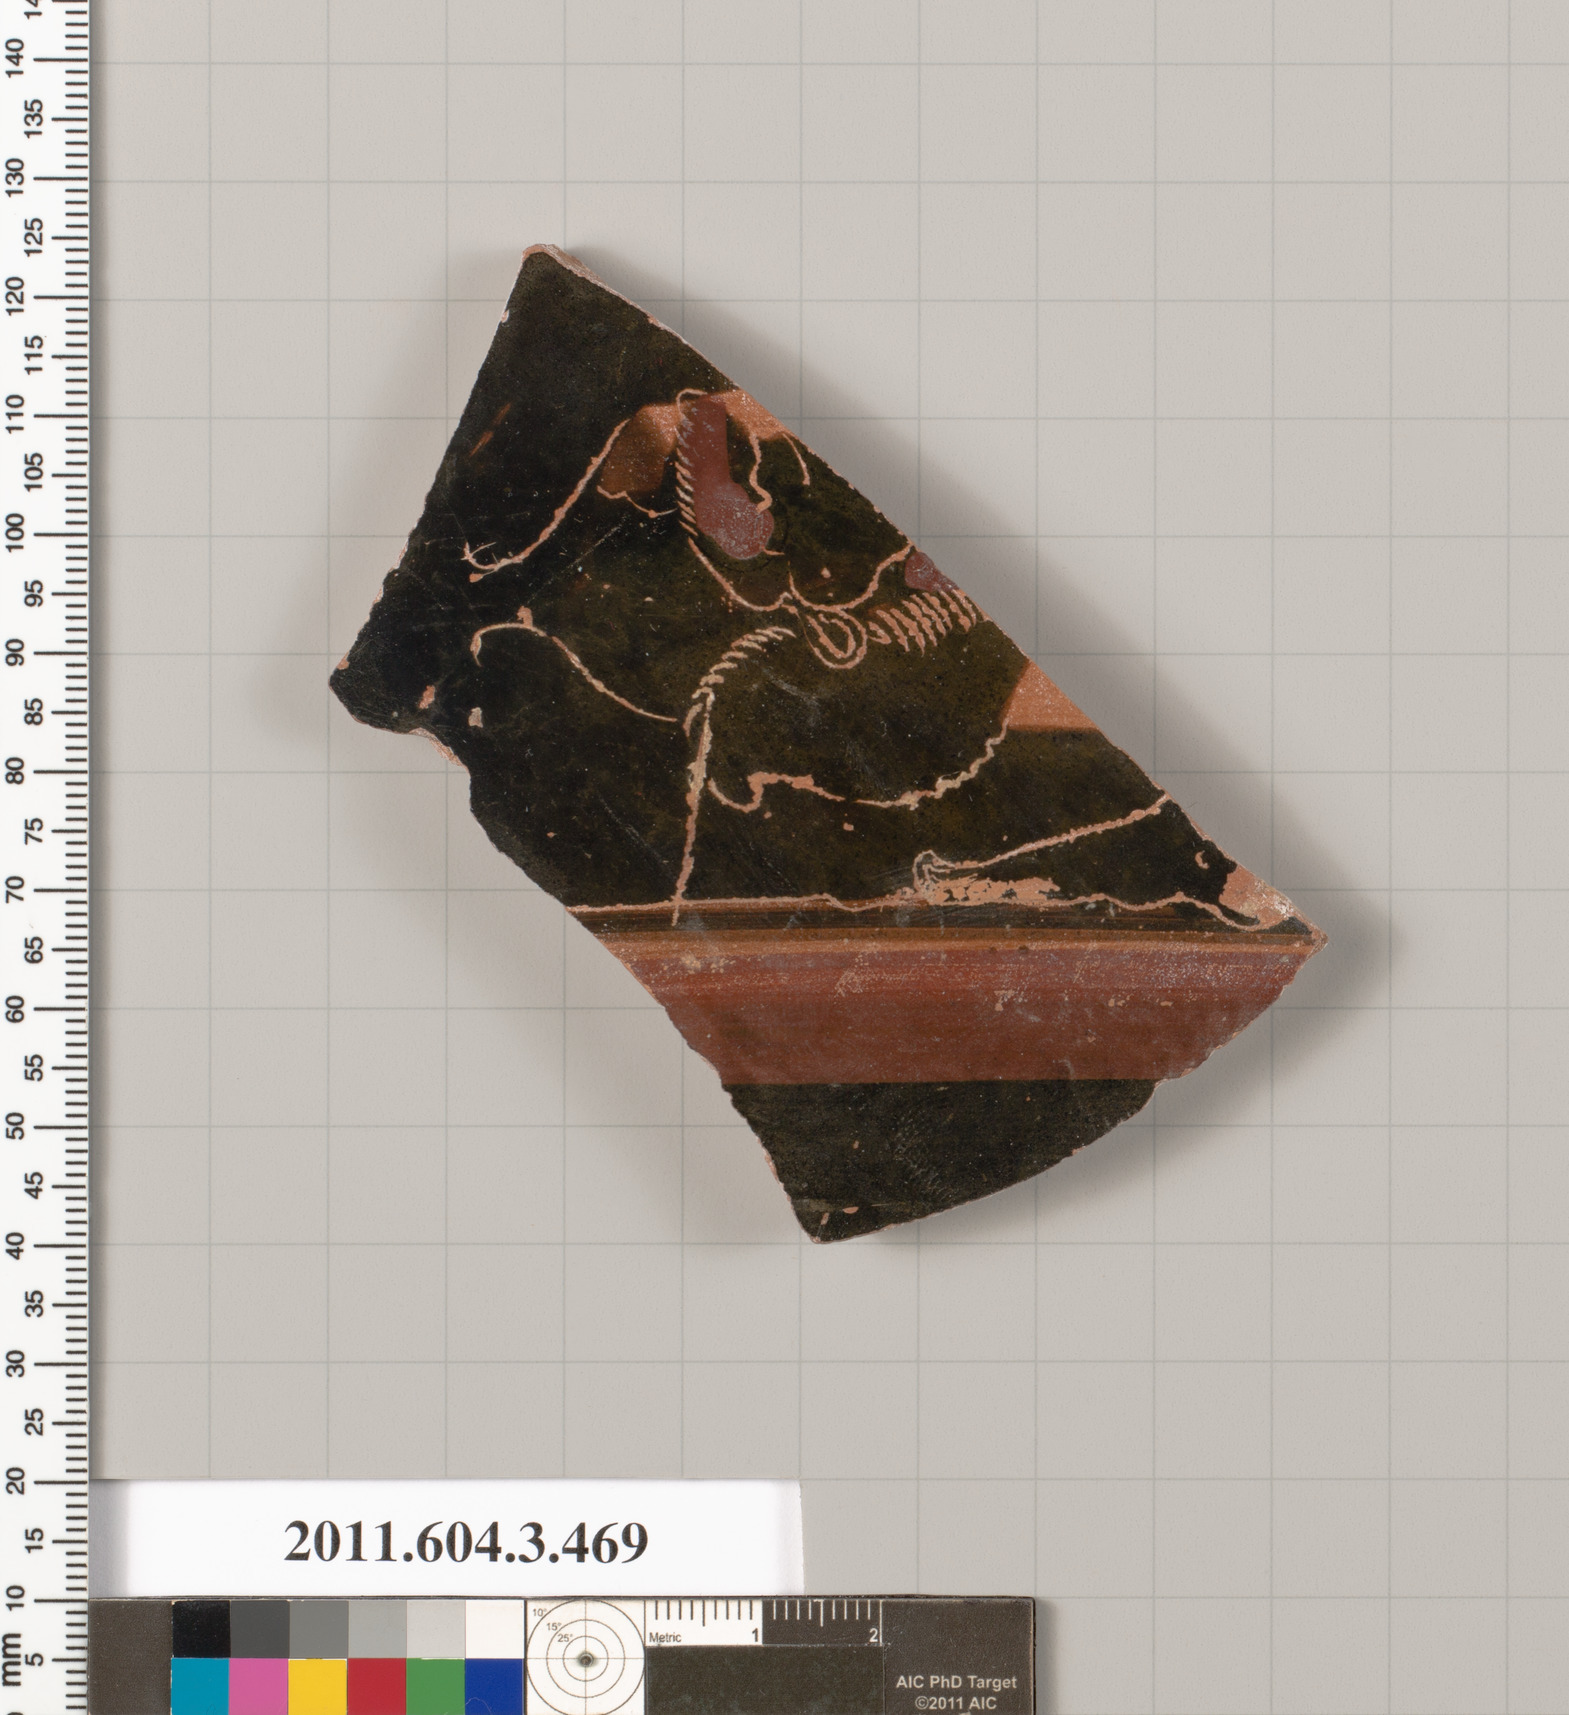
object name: panathenaic prize amphora fragment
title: Terracotta fragment of a Panathenaic prize amphora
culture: greek, attic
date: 534-468 BCE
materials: terracotta